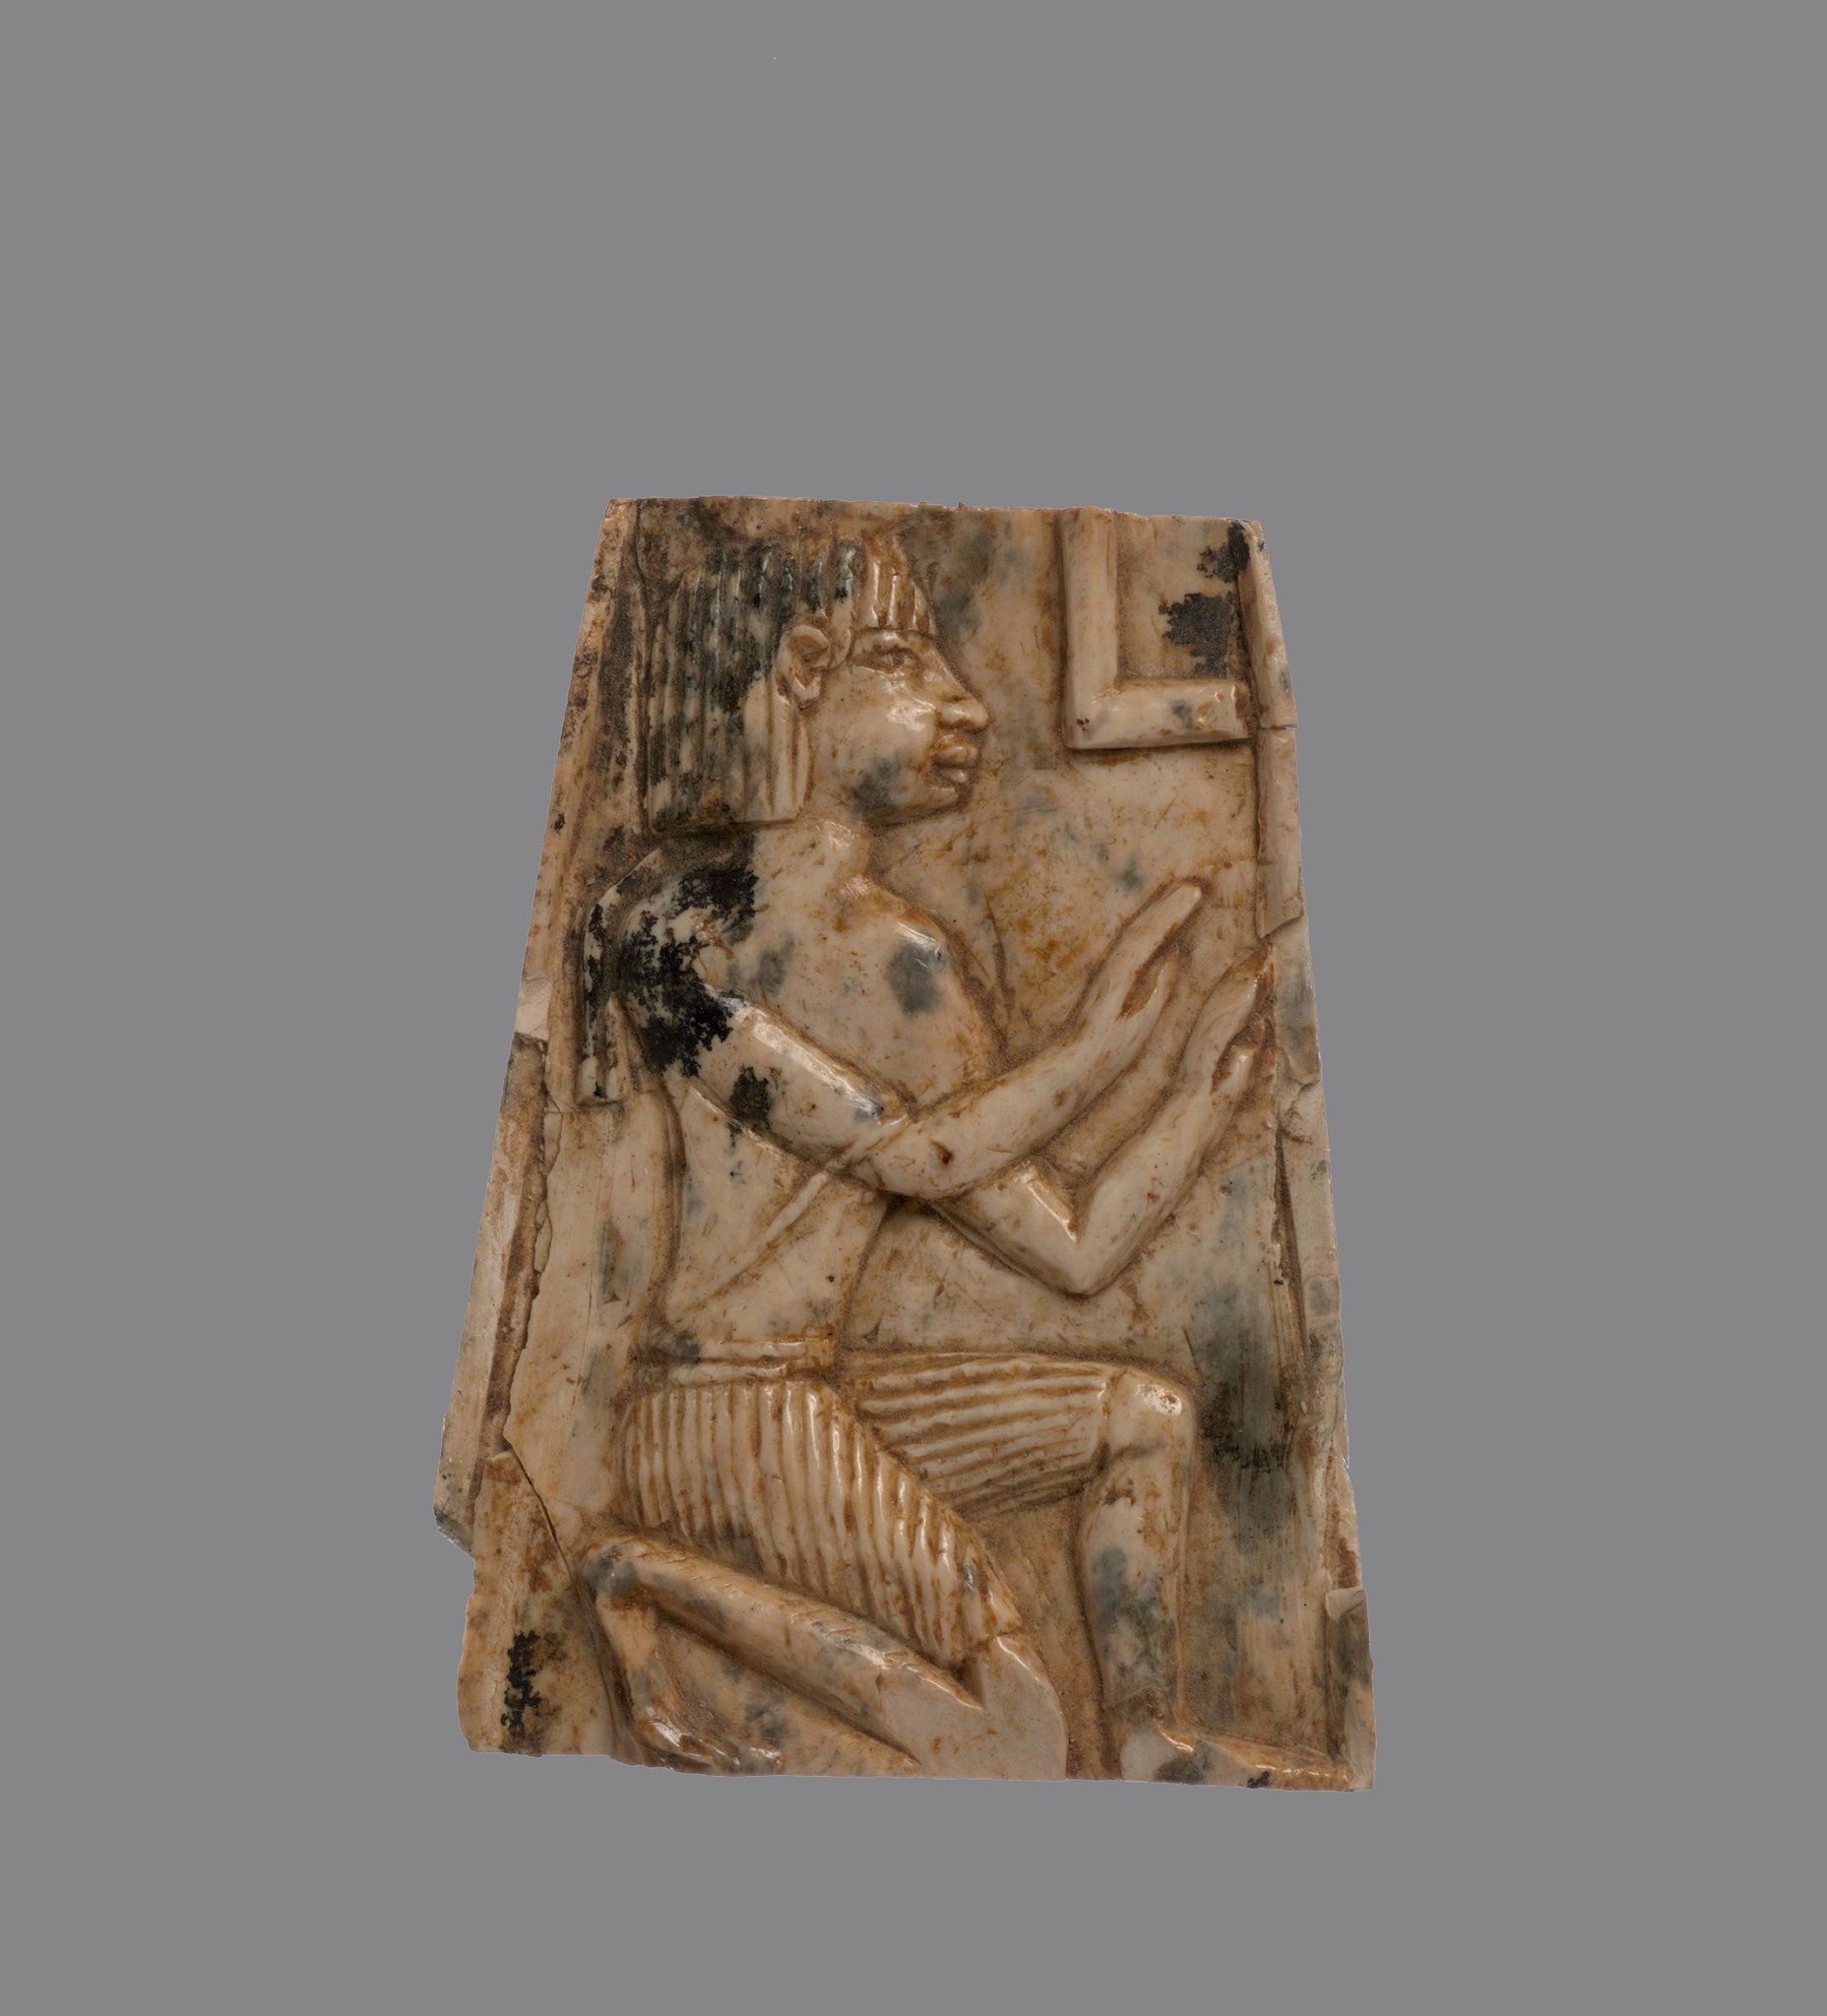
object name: relief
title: Plaque carved in relief with kneeling figure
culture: assyrian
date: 800-601 BCE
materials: ivory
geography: mesopotamia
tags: men